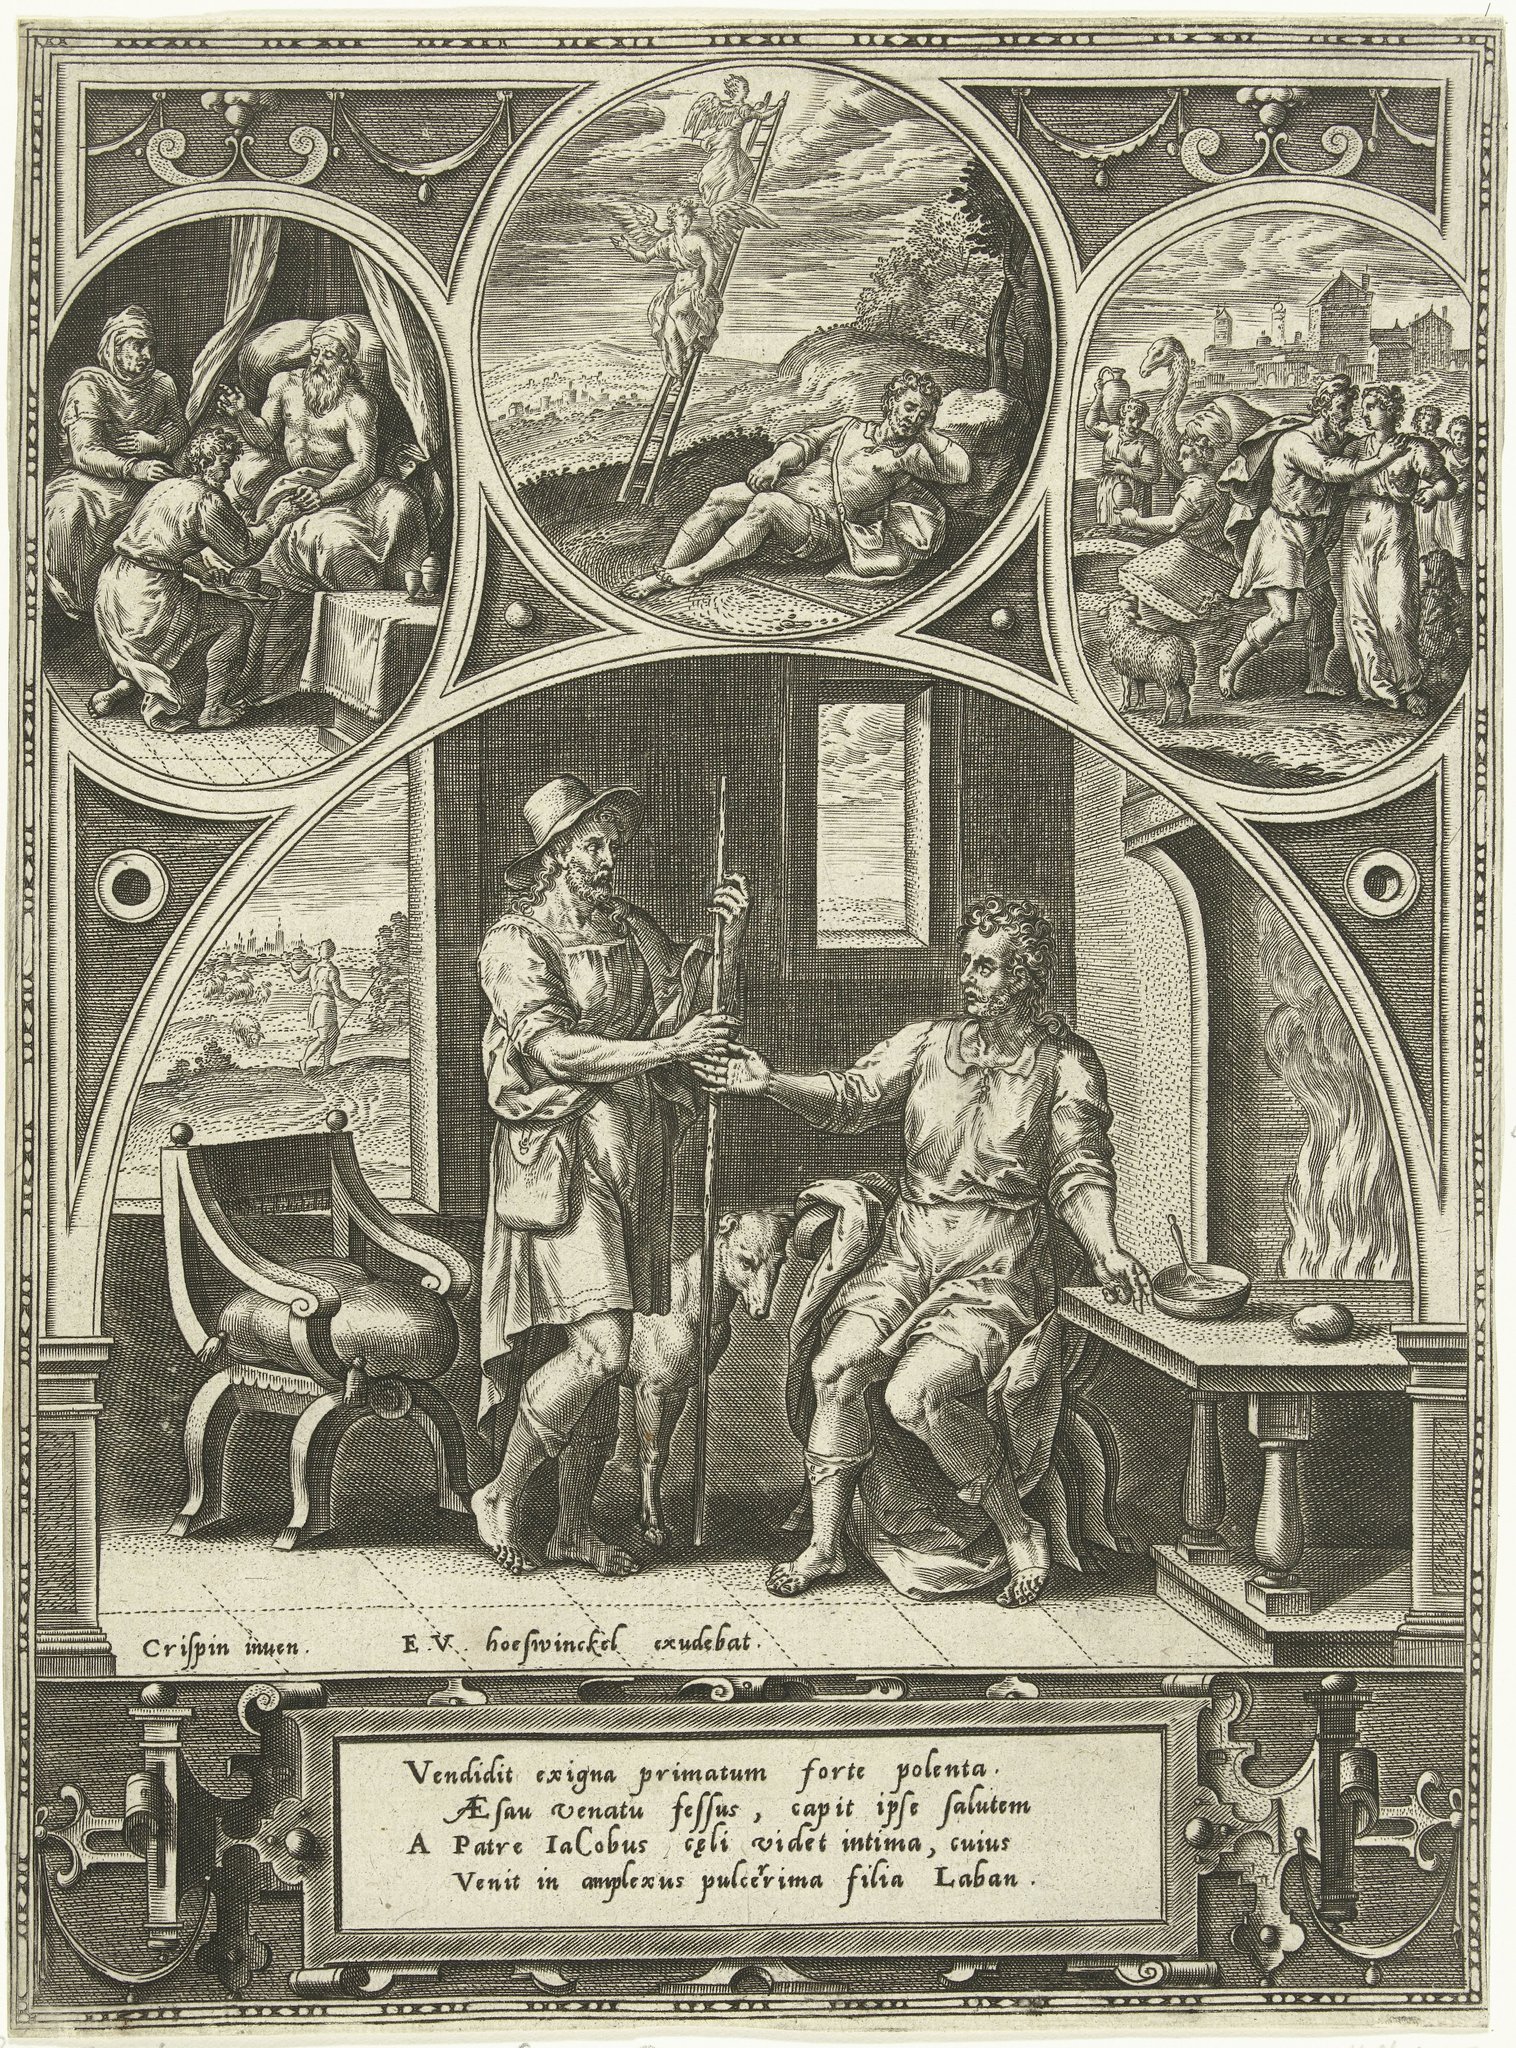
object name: print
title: Scènes uit Genesis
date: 1579-1583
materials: paper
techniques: engraving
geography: antwerp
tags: isaac lying in bed blesses jacob who, disguised in esau's clothes, brings food to his father; jacob's hands and neck are covered with goatskins, the dream of jacob: while sleeping on the ground with a stone for pillow jacob sees a ladder reaching from earth to heaven with angels going up and down; usually with god at the top of the ladder, jacob moves the stone which covers the opening of the well and waters rachel's sheep, esau, returning hungry from the hunt, sells his first birthright to jacob for a pottage of lentils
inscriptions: collector's mark: Lugt 240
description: De hongerige Esau verkoopt zijn geboorterecht als eerstgeborene aan Jakob voor een bord linzensoep. Boven, drie medaillons met afbeeldingen met gebeurtenissen die betrekking hebben op Jakobs leven. Links misleidt Jakob zijn vader Isaak, die hem onbewust uitroept tot erfgenaam. In het midden de droom van Jakob. Rechts de eerste ontmoeting tussen Rachel en Jakob bij de waterput. De prent heeft een Latijns onderschrift in een cartouche. De prent is deel van een serie met scènes uit het Bijbelboek Genesis.